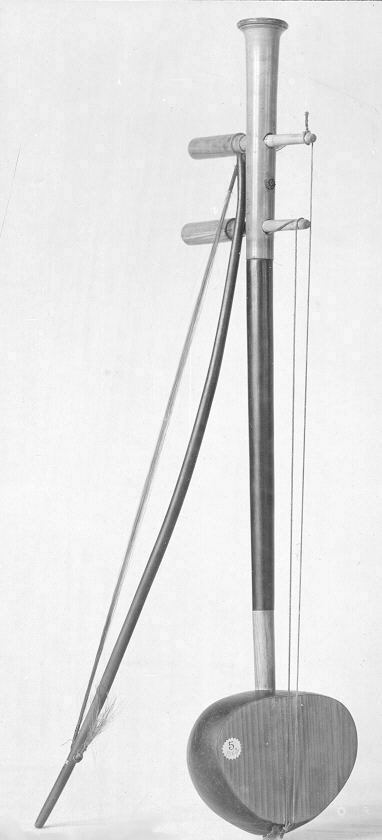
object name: saw u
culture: thai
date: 1867-1900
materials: plant material, ivory, wood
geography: thailand